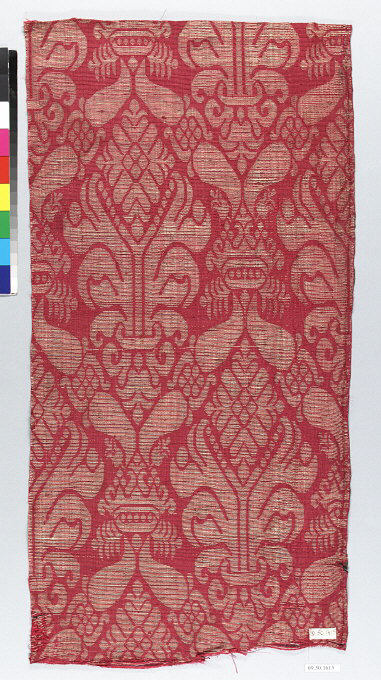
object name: piece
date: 1501-1600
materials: metal thread, silk